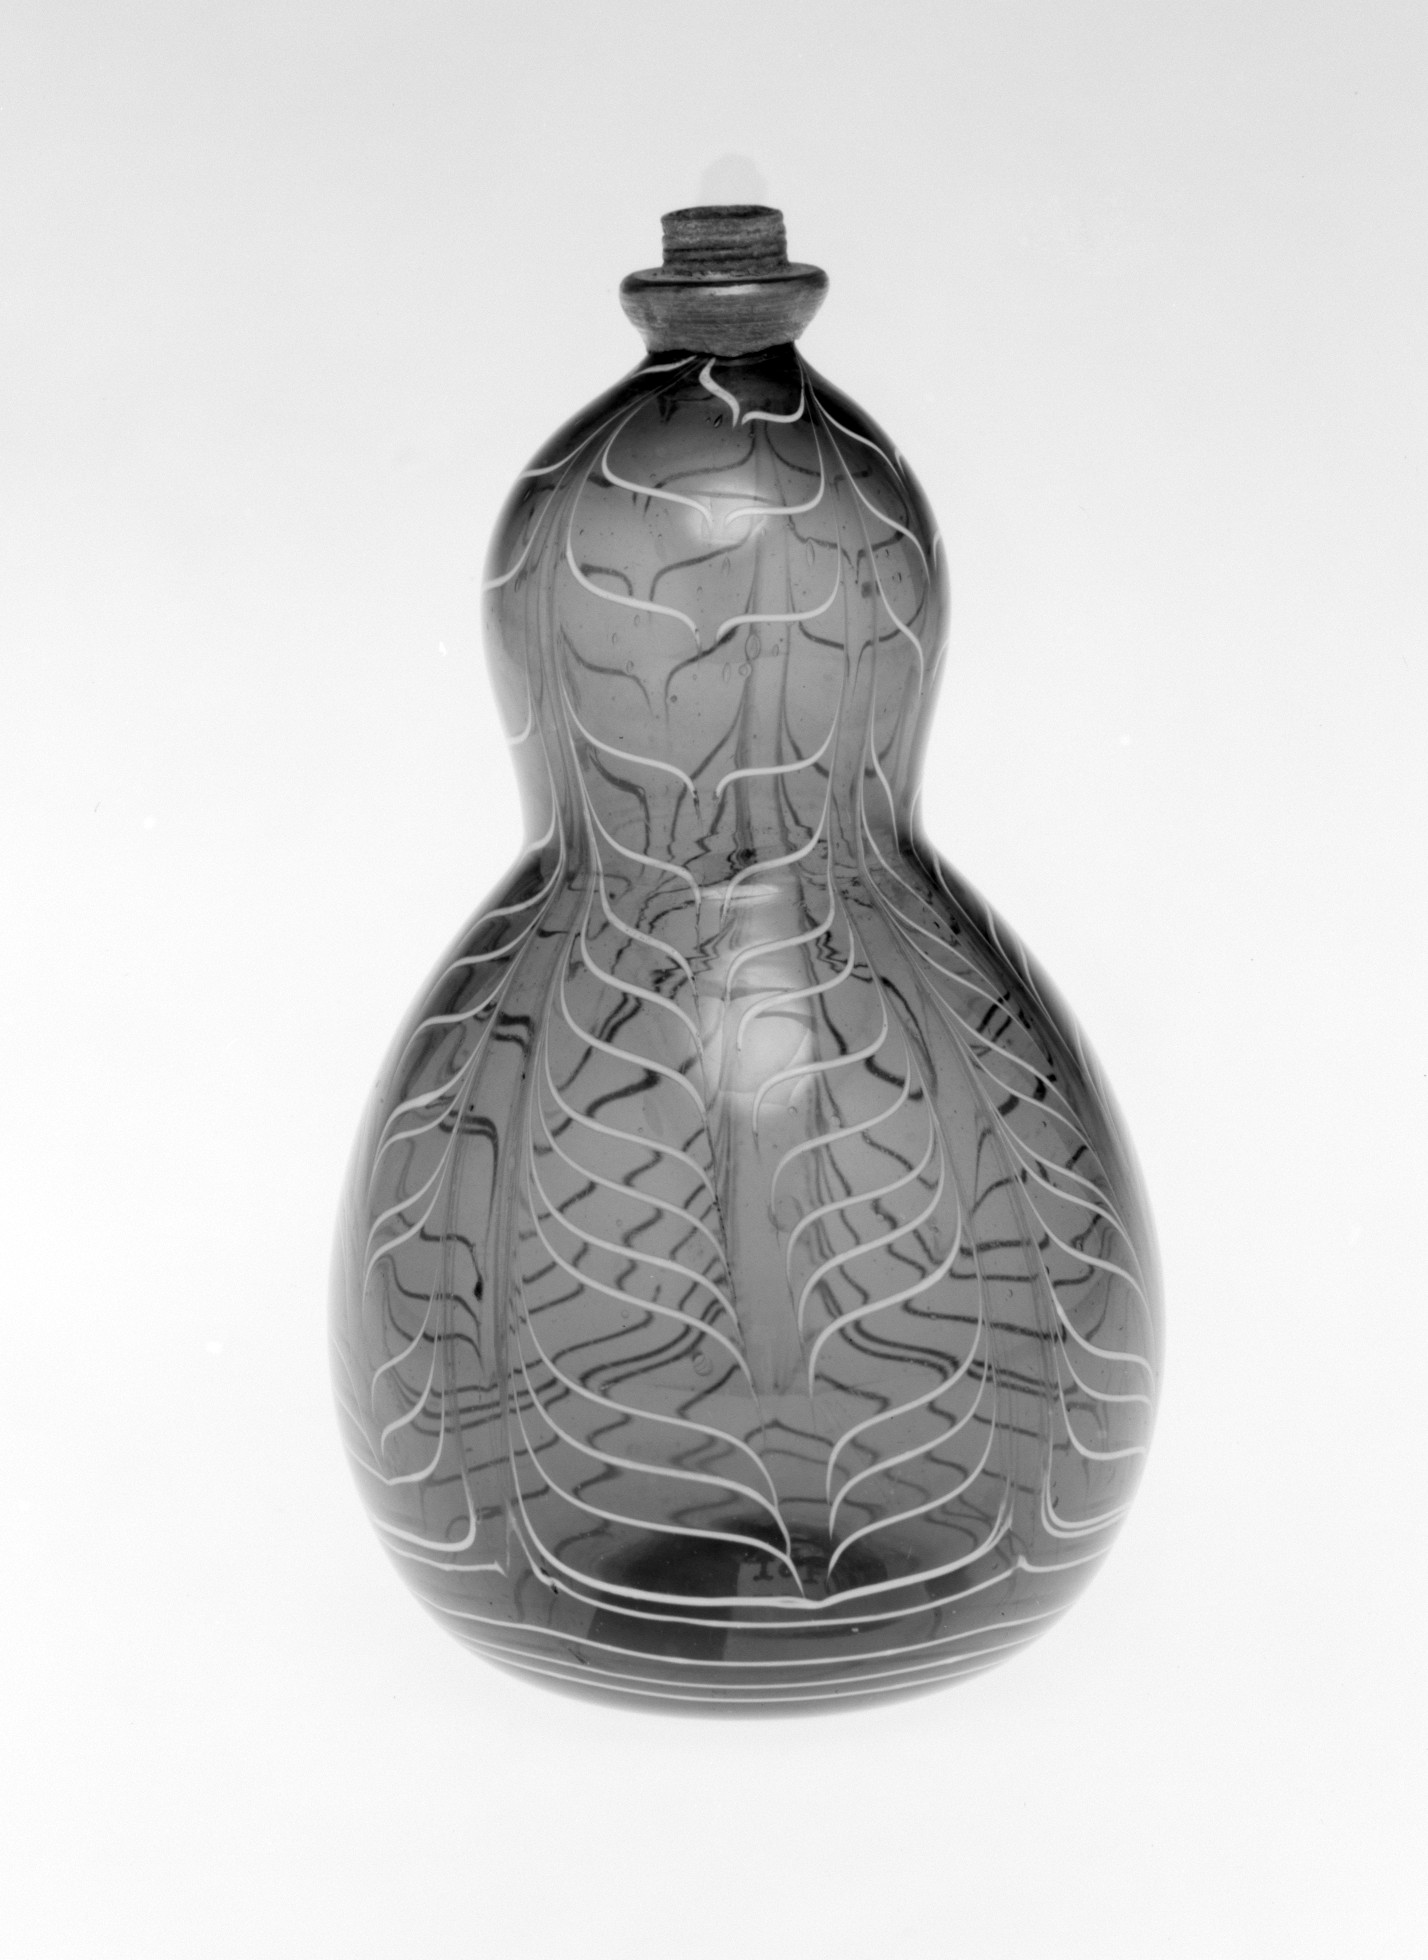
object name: bottle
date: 1701-1800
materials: glass, metal